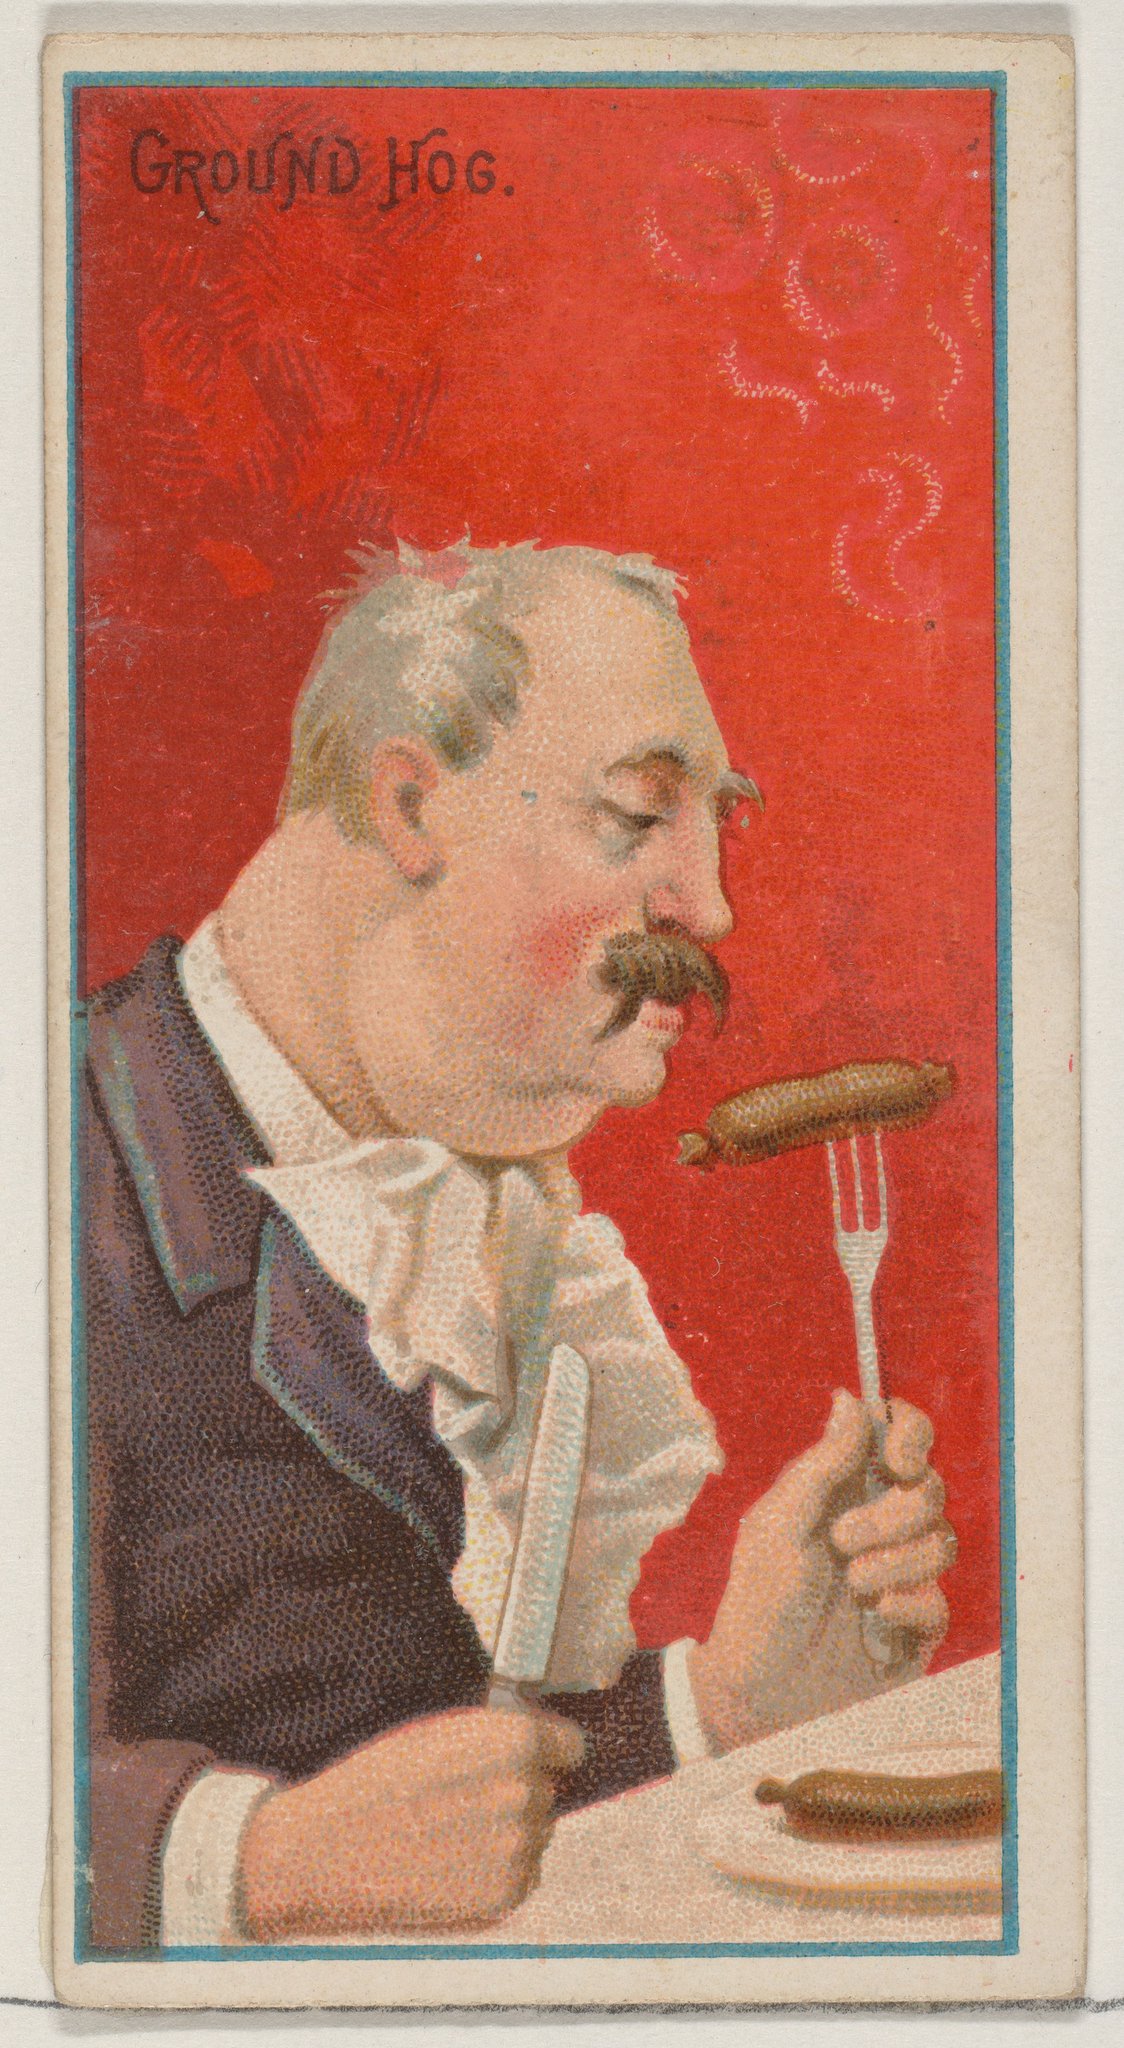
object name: print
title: Ground Hog, from the Jokes series (N87) for Duke brand cigarettes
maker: w. duke, sons & co.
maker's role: publisher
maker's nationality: american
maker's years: 1870-1920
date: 1890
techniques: color lithograph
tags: food,men,dining